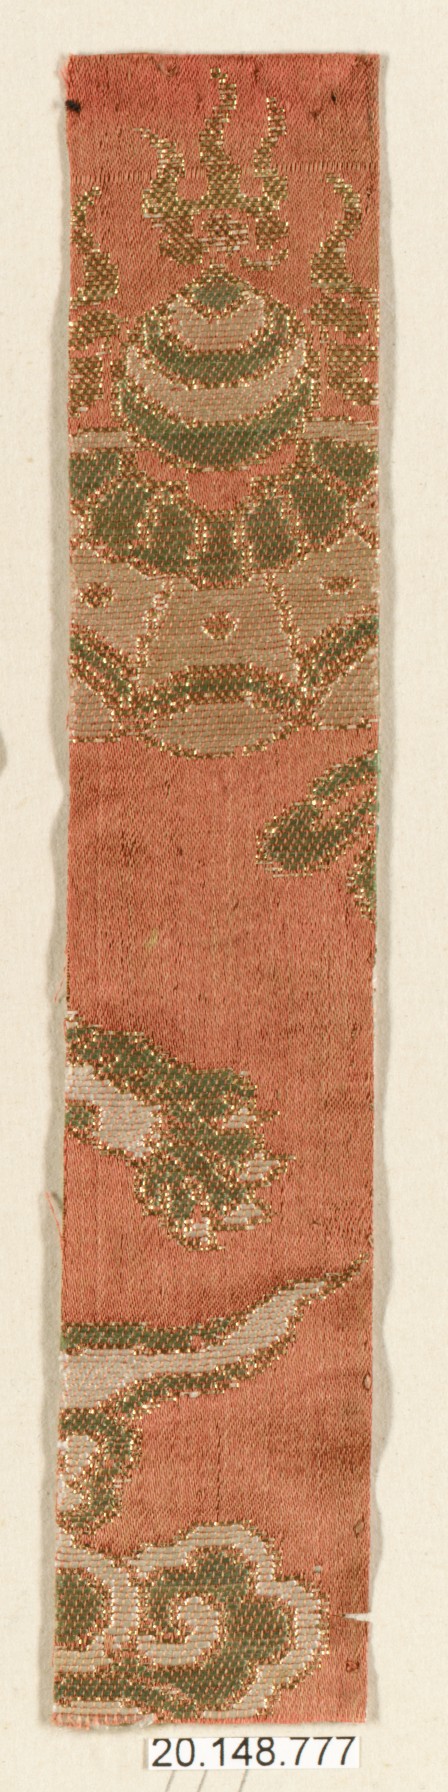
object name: piece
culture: japanese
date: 1601-1700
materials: silk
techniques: compound weave